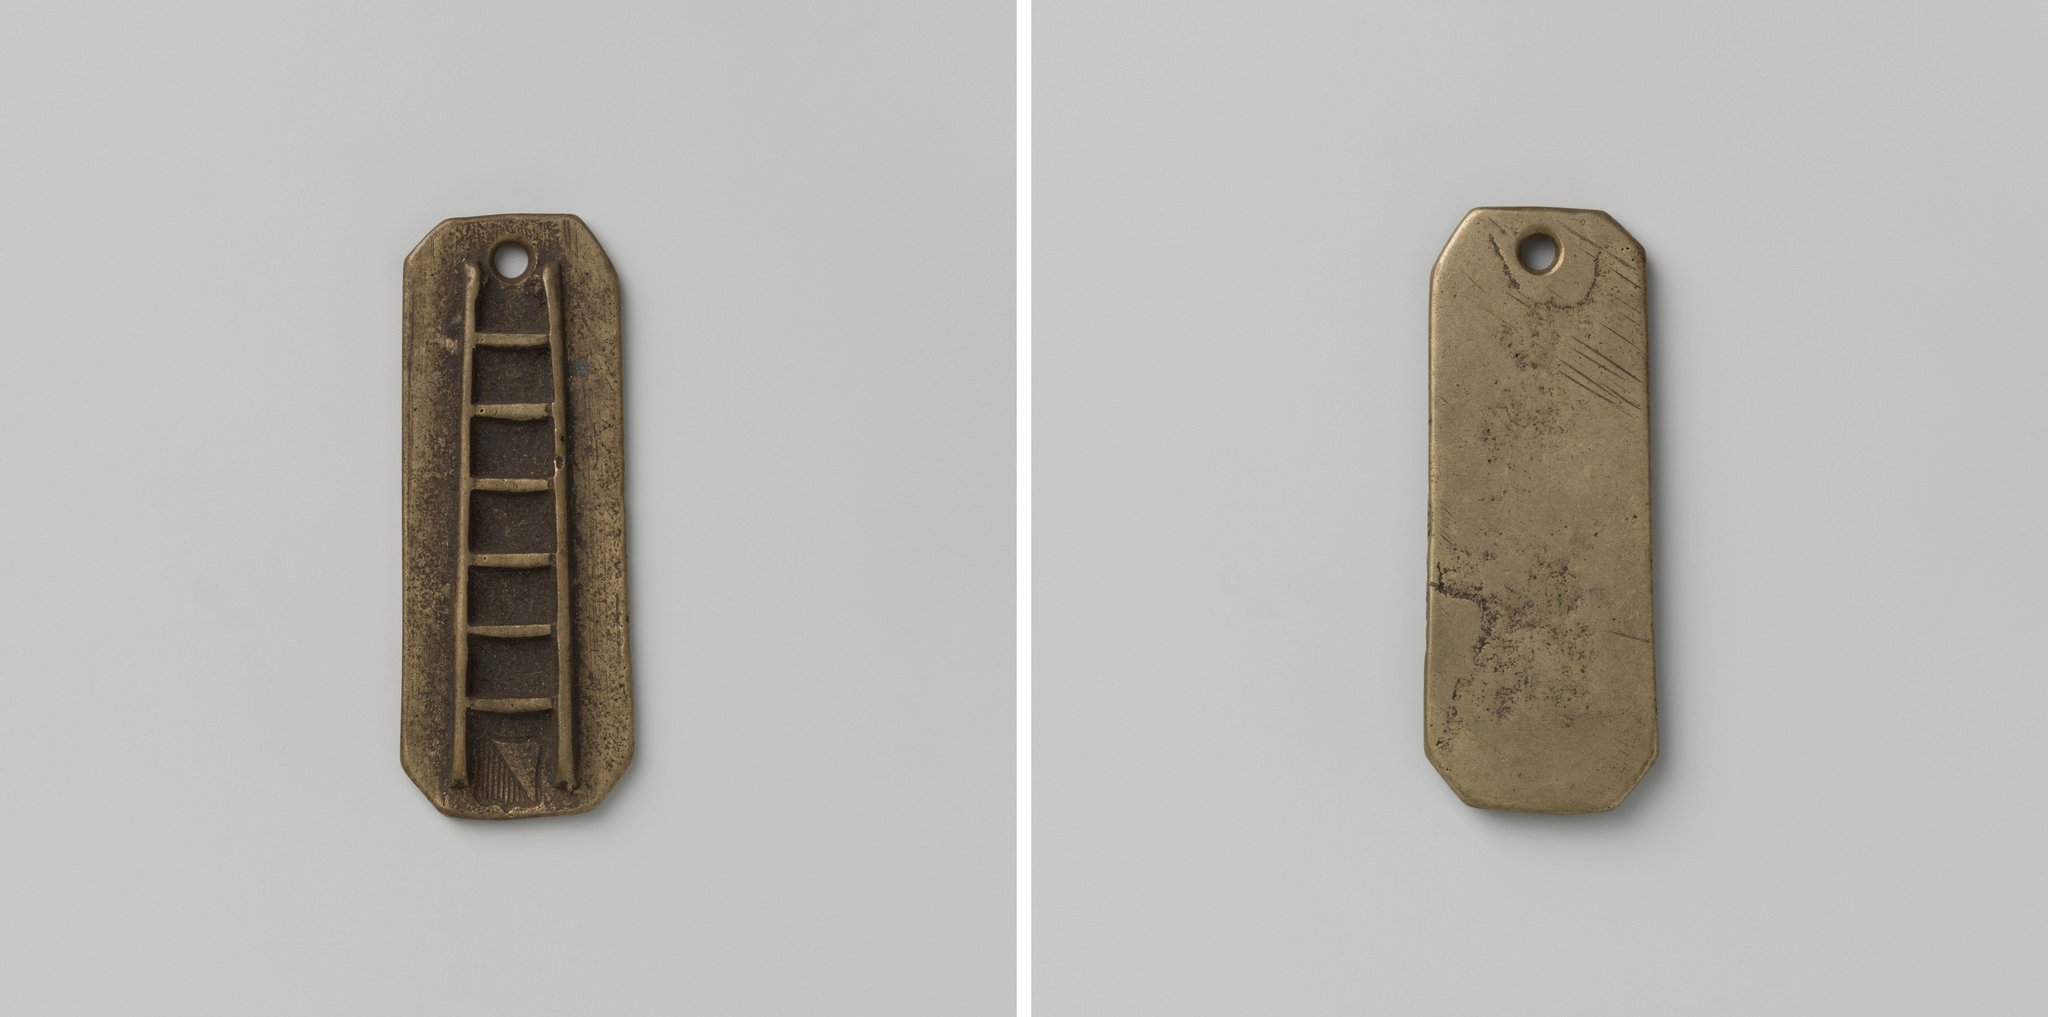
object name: insignia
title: Utrecht, insigne van de brandweer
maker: Anonymous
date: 1650-1850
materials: brass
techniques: casting, striking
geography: utrecht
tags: utrecht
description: eenzijdig, langwerpig, taps toelopend insigne met afgeschuinde hoeken en aan bovenzijde gat. Voorzijde: ladder met zes treden in hoog relief; onderaan, tussen stijlen van ladder: wapenschild. Keerzijde: blanco